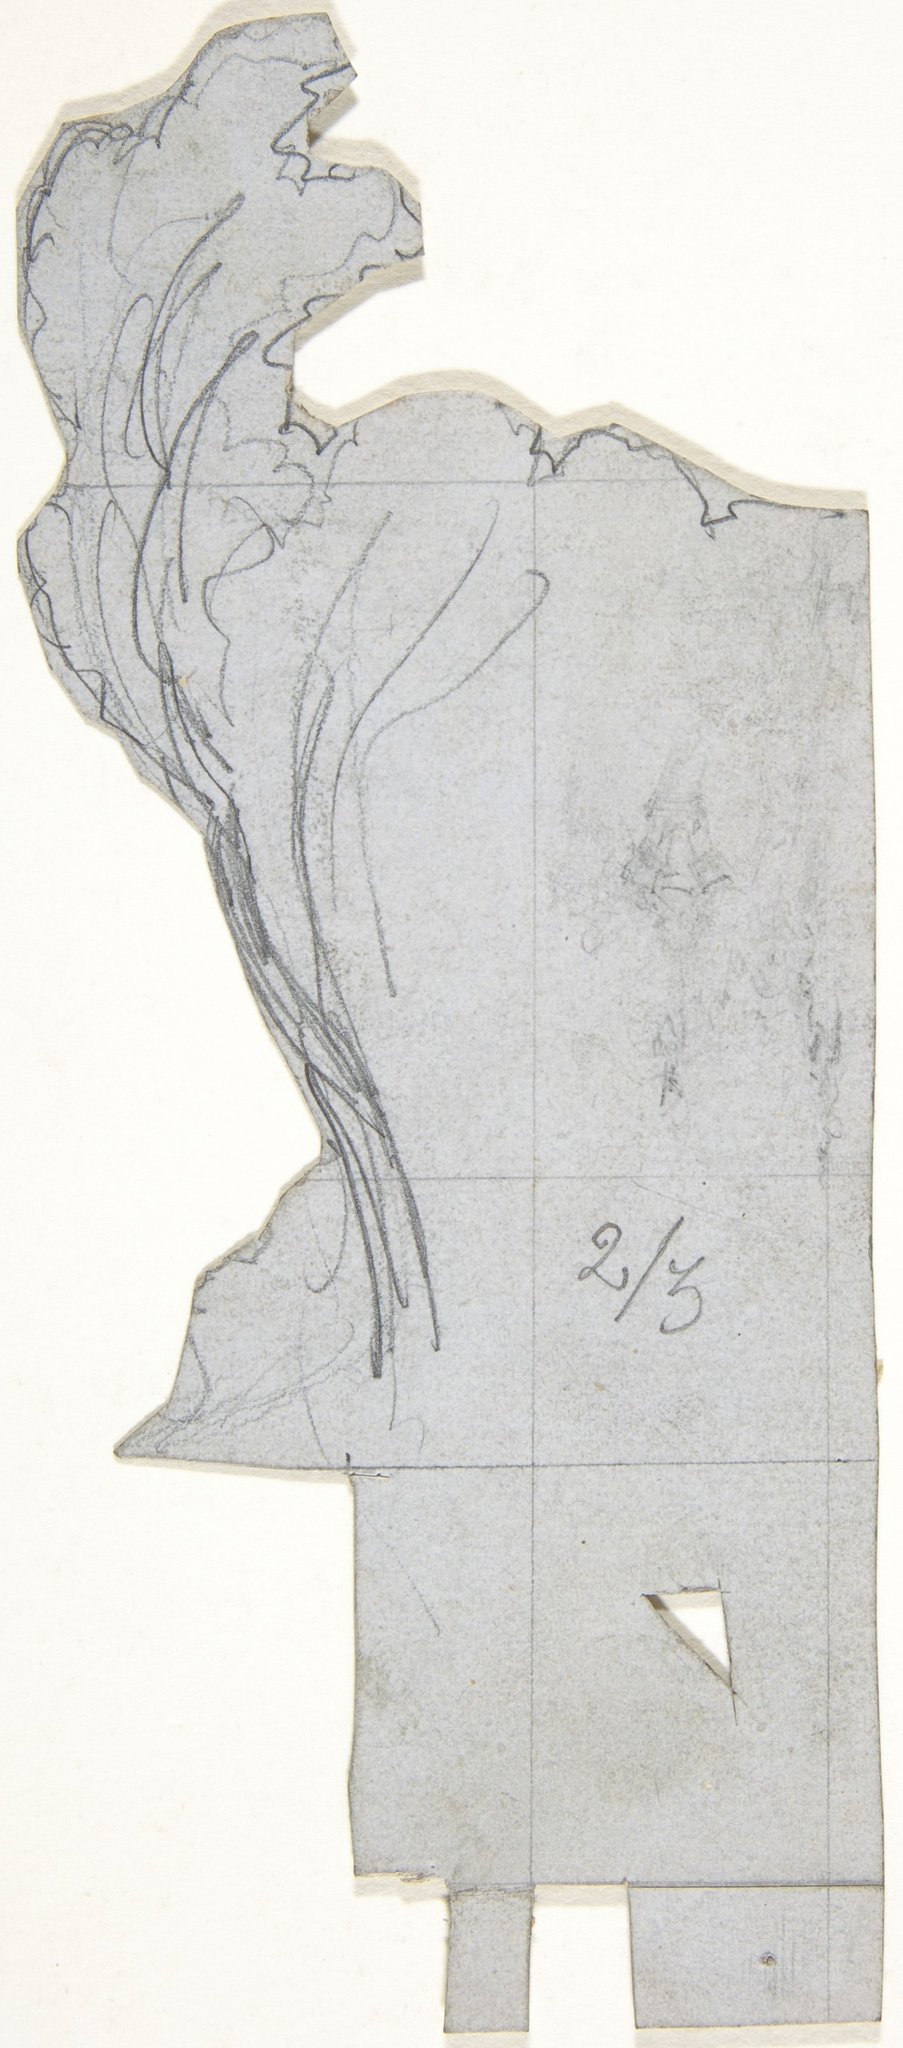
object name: drawing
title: Design for a Stage Set at the Opéra, Paris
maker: eugène cicéri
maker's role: artist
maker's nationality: french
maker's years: 1813-1890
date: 1830-1890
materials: graphite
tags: stage design